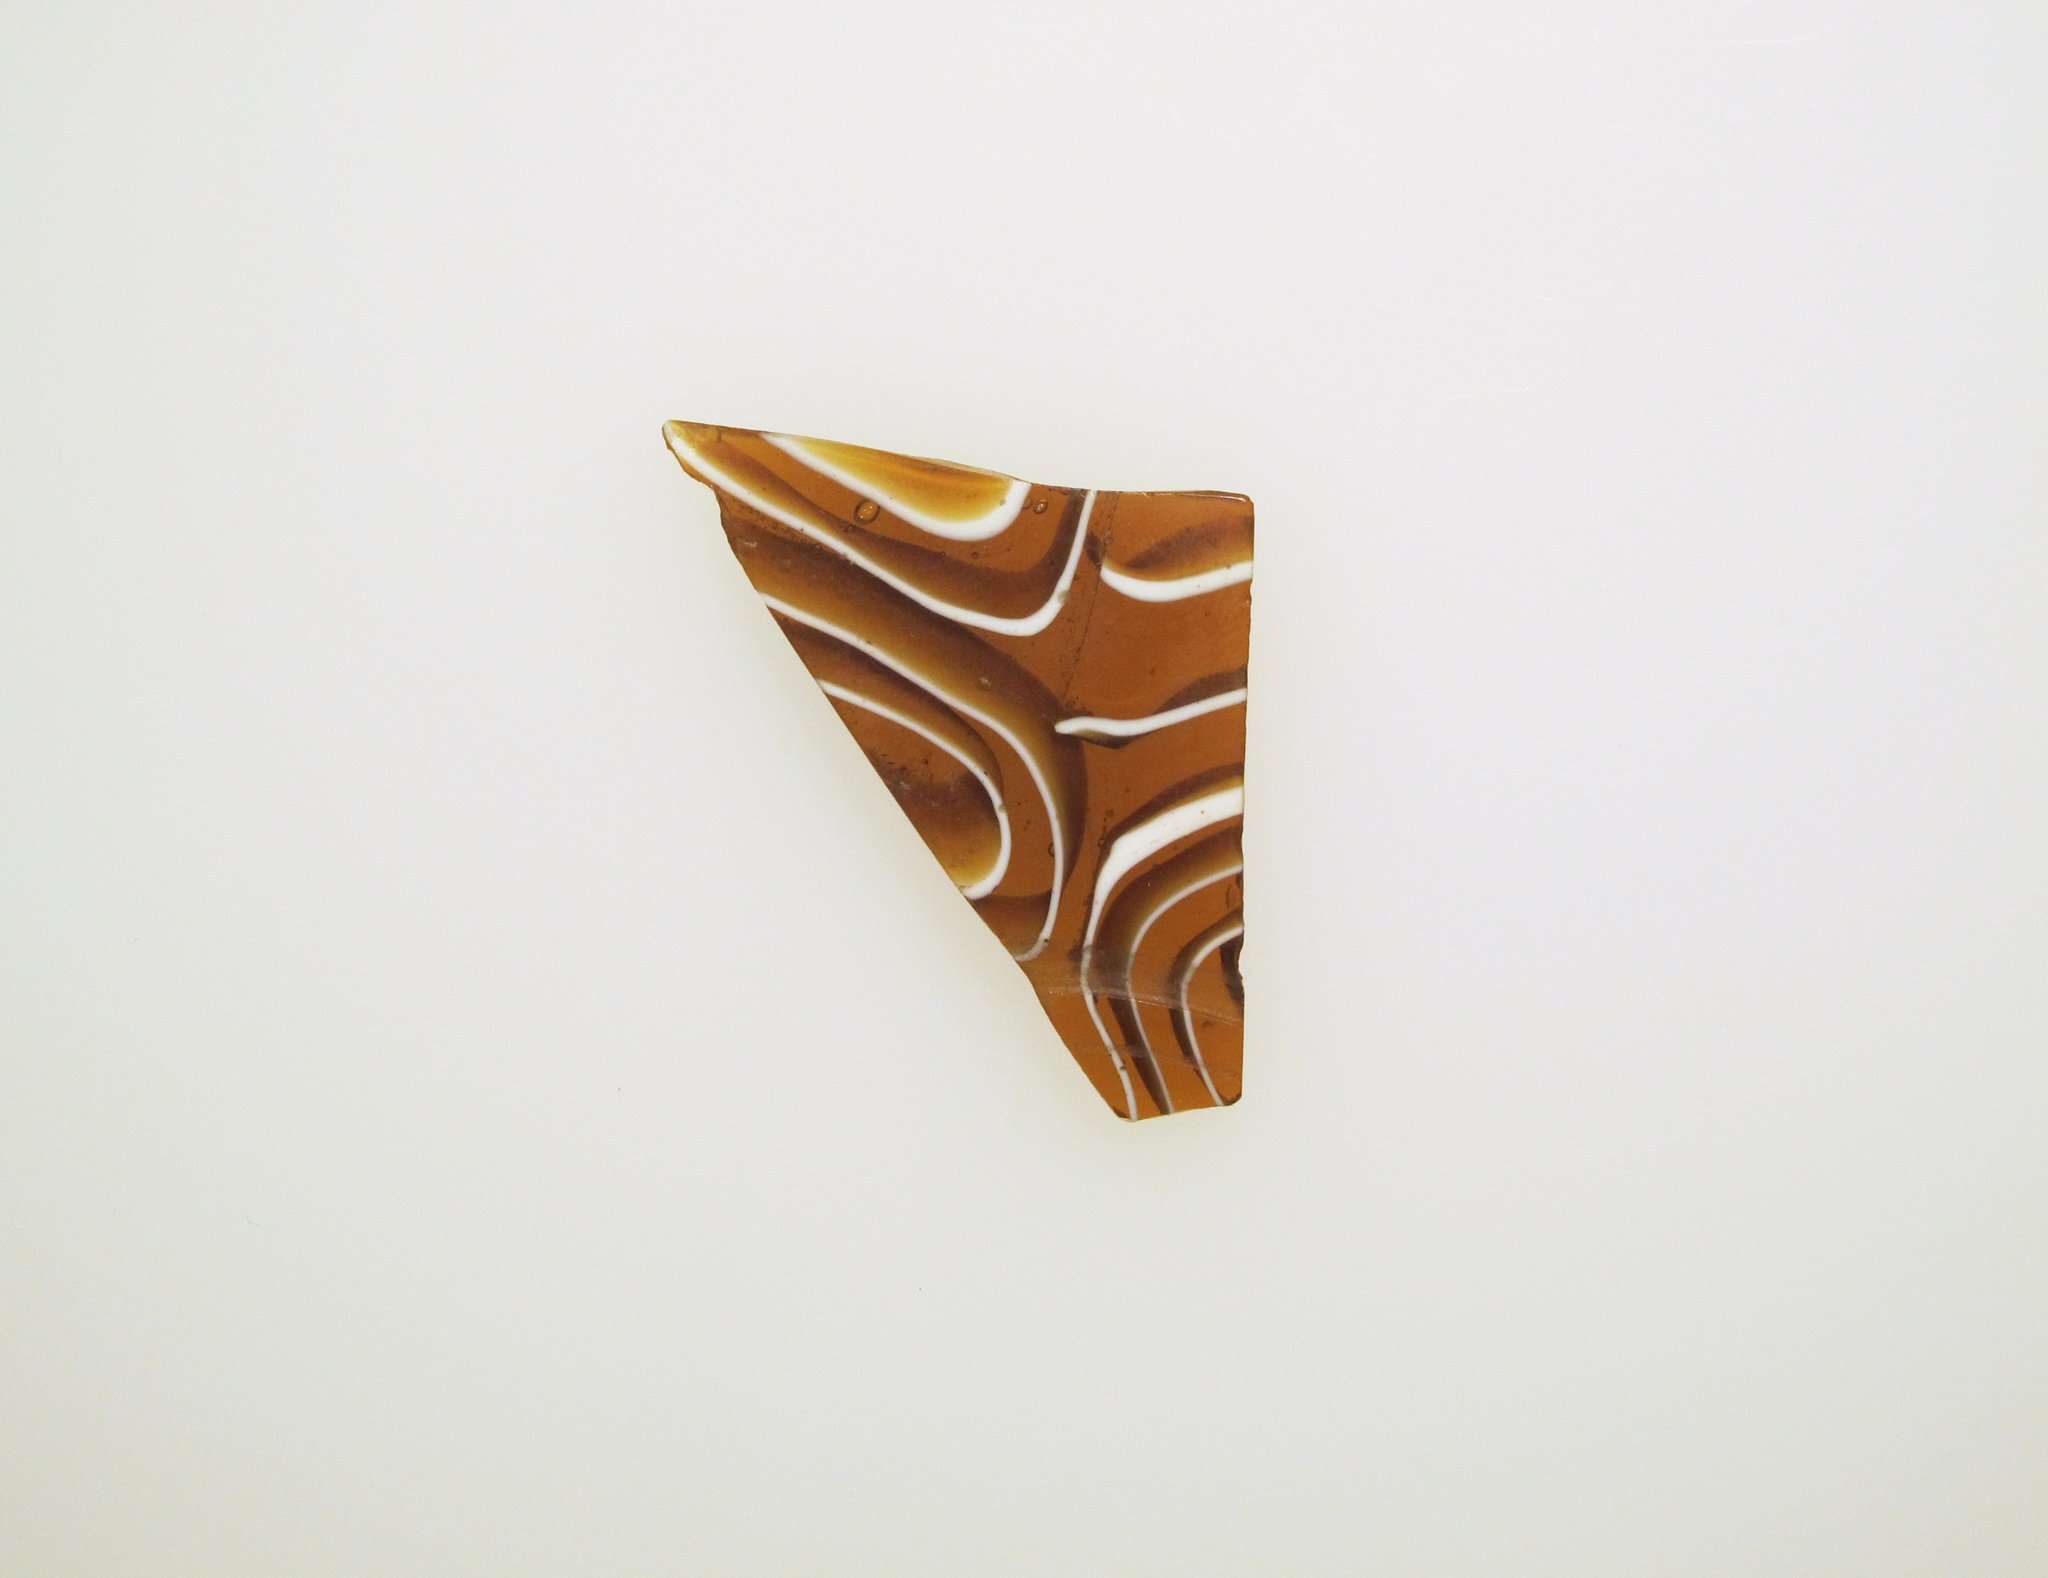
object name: millefiori bowl, fragmentary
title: Glass mosaic bowl fragment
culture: roman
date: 34 BCE-33 CE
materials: glass